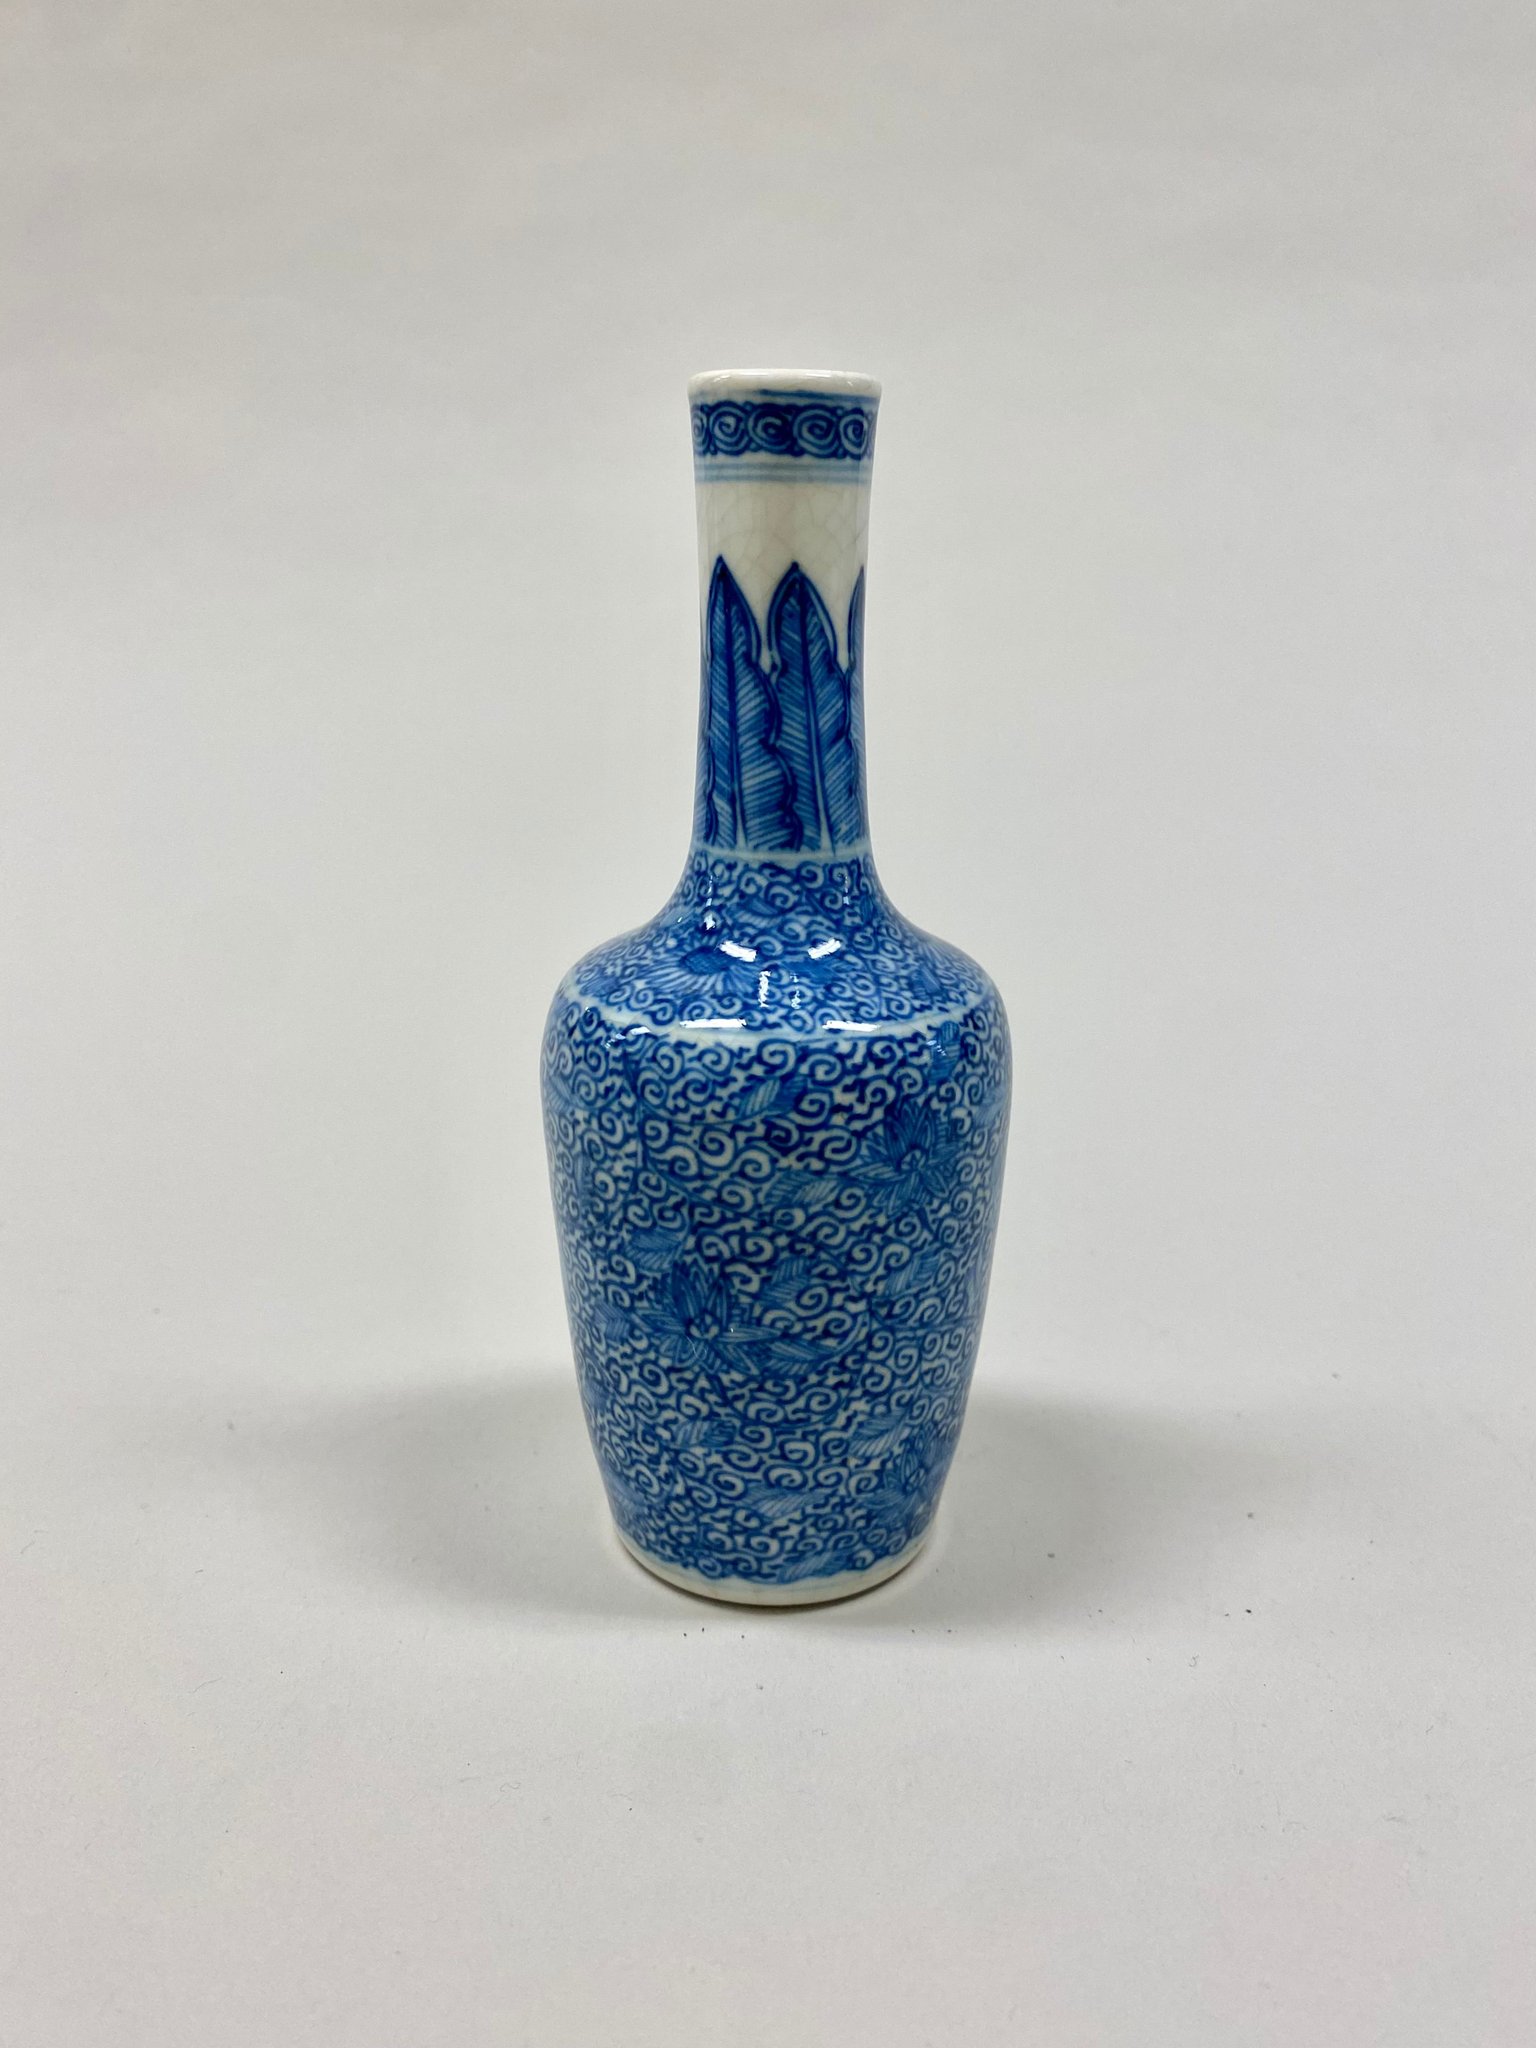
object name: bottle vase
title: Bottle vase with floral scrolls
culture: chinese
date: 1701-1733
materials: cobalt, soft paste porcelain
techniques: painting, underglaze